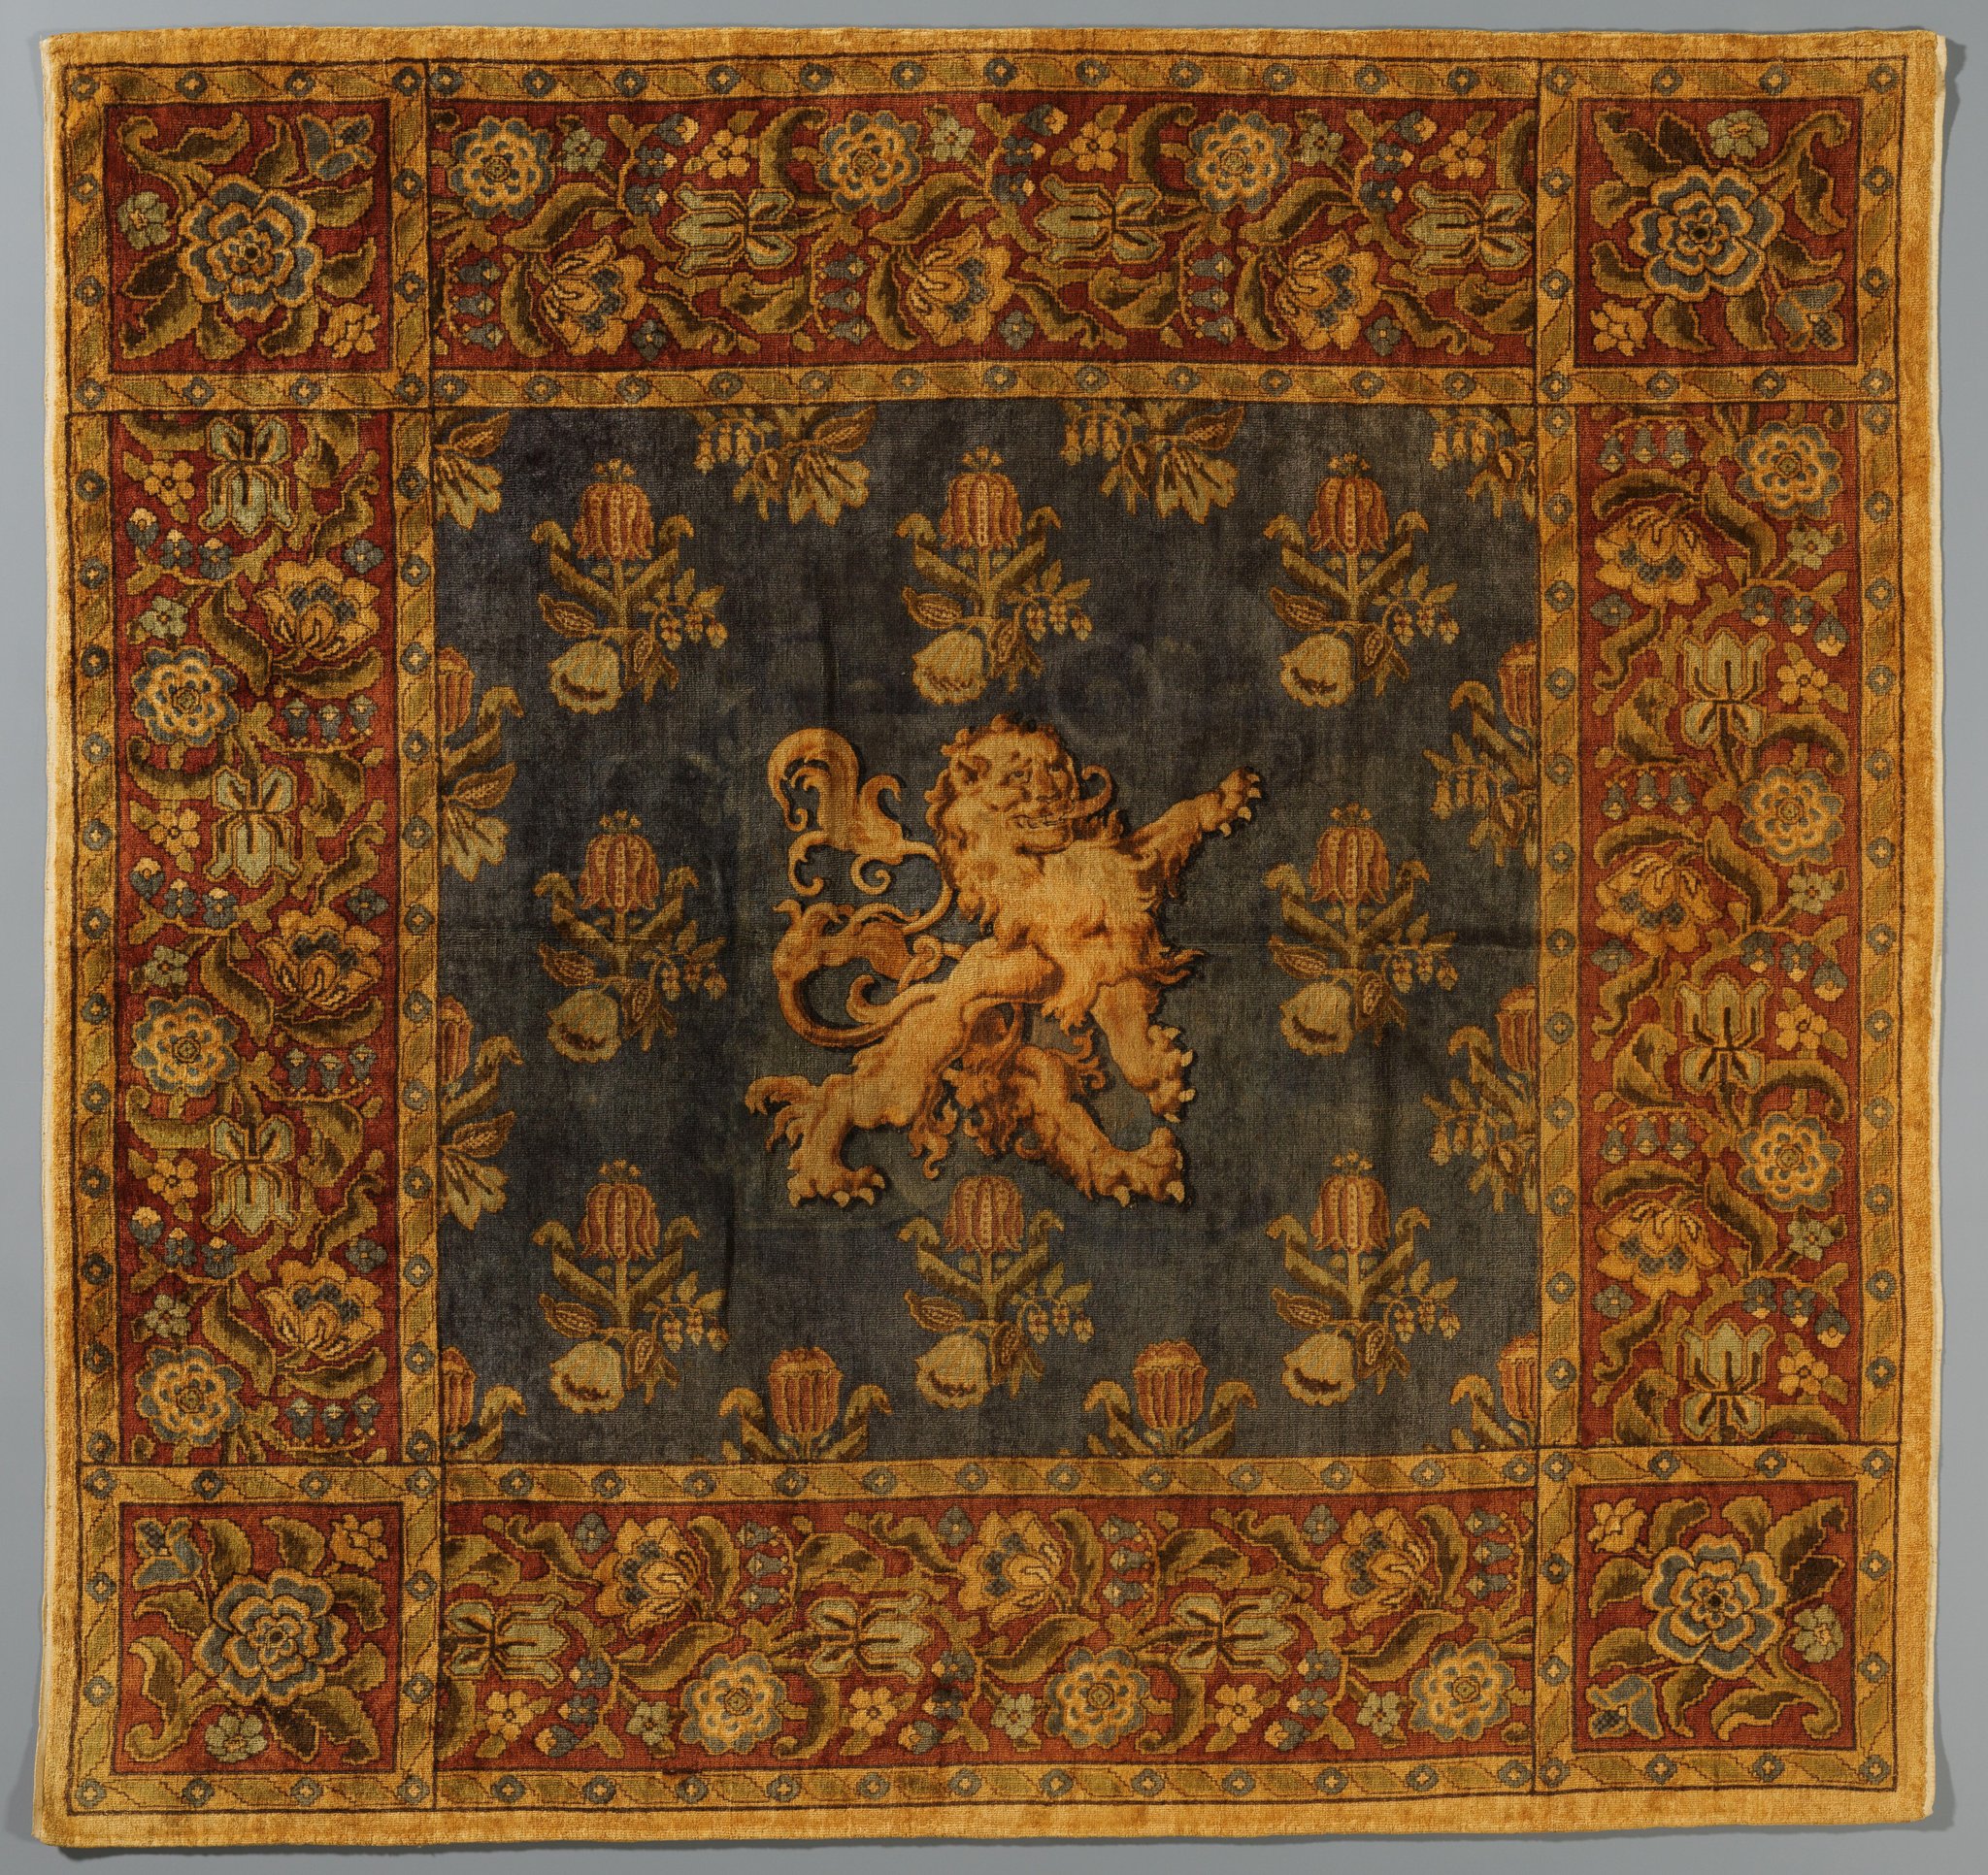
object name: tafelkleed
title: Tafelkleed van bedrukte fluweel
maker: Anonymous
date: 1850-1870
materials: cotton, linen, velvet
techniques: printing, weave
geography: netherlands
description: Pluche tafelkleed; in het blauwe middenveld een leeuw waaromheen toeven bloemen.